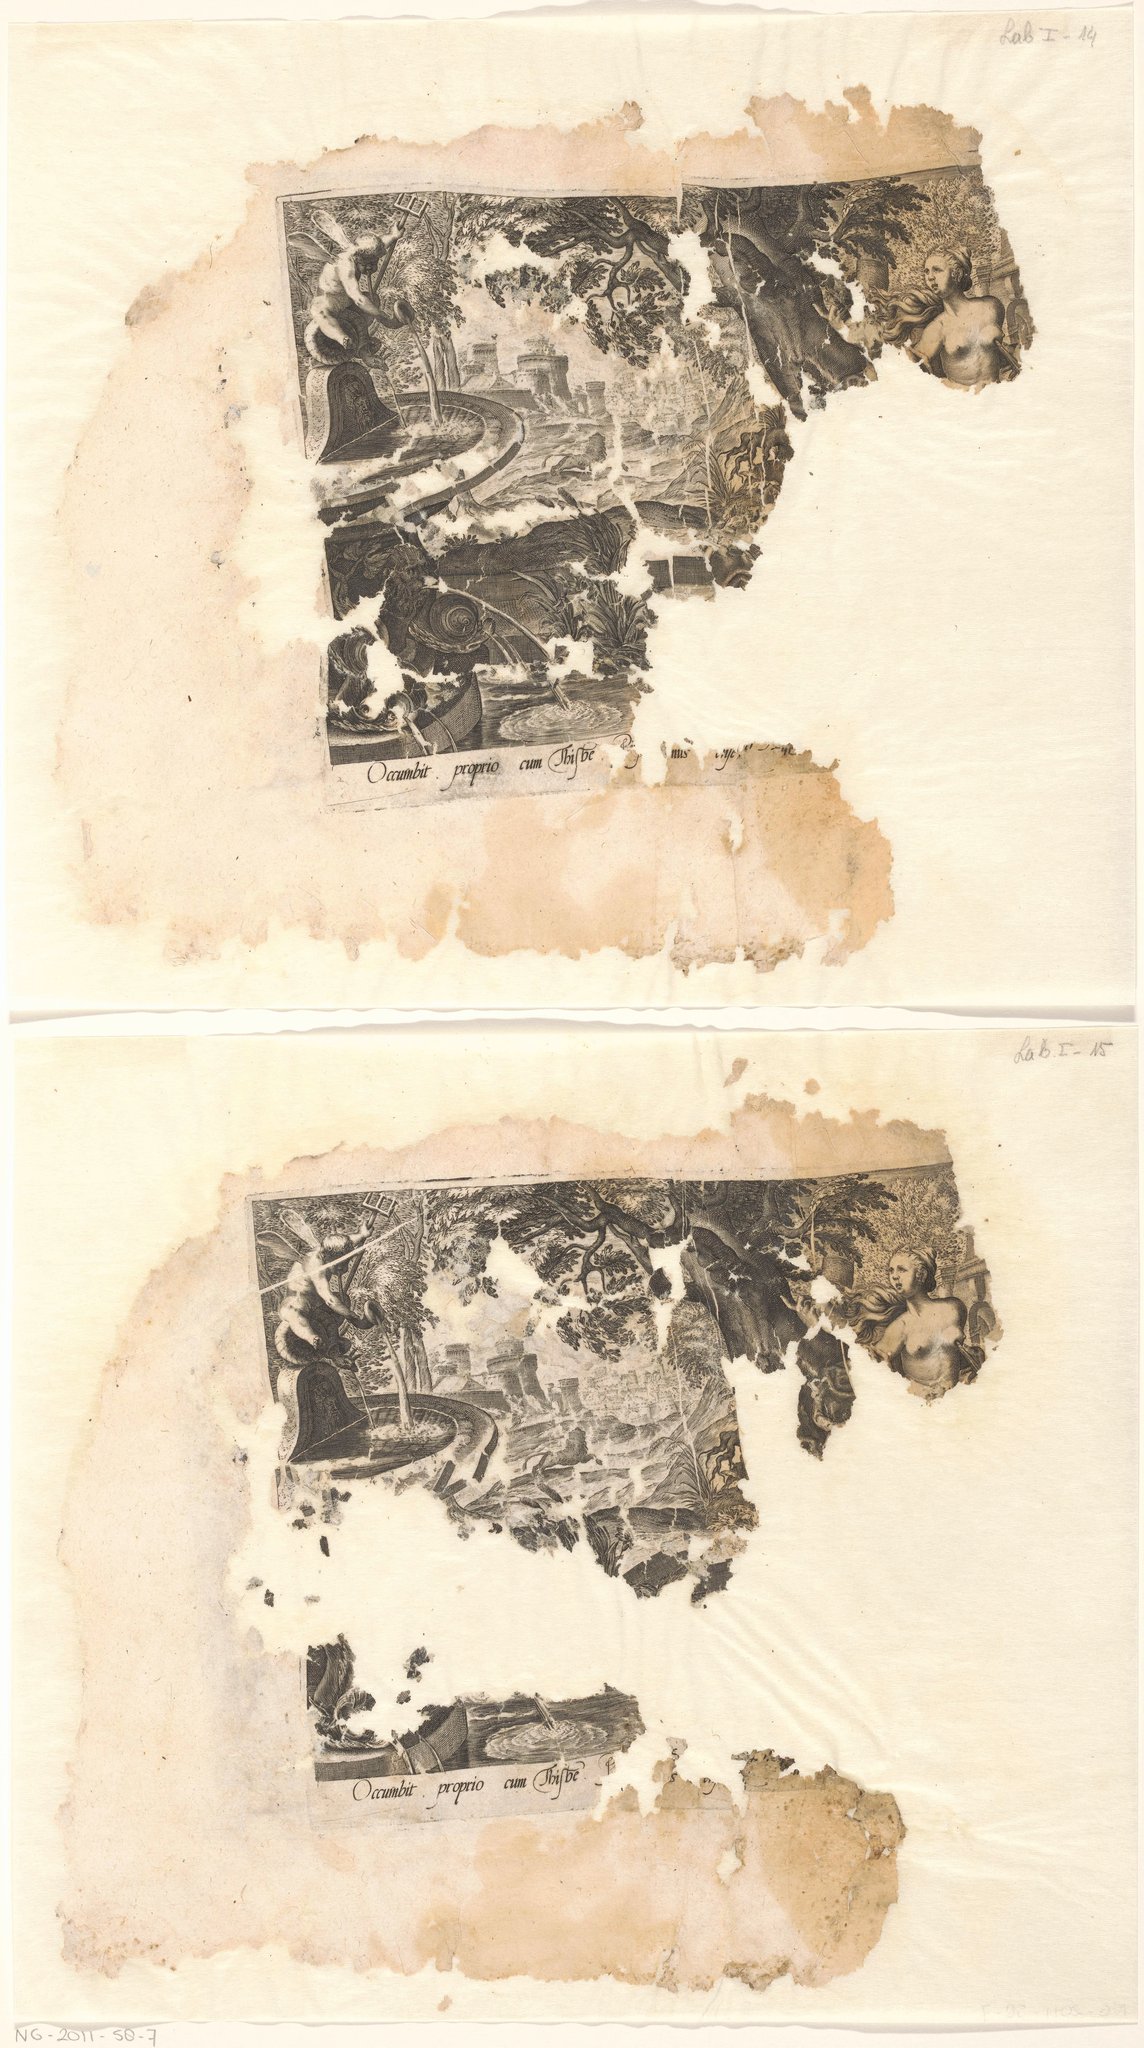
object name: print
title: Pyramus en Thisbe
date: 1580-1596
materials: paper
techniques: engraving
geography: northern netherlands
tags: thisbe kills herself with pyramus' sword (the scene may be represented near a fountain)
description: De prenten in de Nova Zembla collectie zijn tijdens een expeditie van Willem Barendsz en Jacob van Heemskerk in 1596-1597 noodgedwongen in het winterkamp, het ‘Behouden Huis’, op het eiland achtergelaten. De prenten waren in één of meerdere stapels als handelswaar meegenomen vanuit Amsterdam. Bijna drie eeuwen later, in 1871, keerde de Noor Elling Carlsen terug naar Nova Zembla en vond daar de restanten van het ‘Behouden Huis, inclusief een groot deel van de inventaris. Een deel van de prenten, in de vorm van aaneengekoekte kluiten, werd toen ook teruggevonden. De papierkluiten waren soms op meerdere plekken gebroken. Tussen 1975-1979 zijn de prenten van elkaar gescheiden. Dit leverde in totaal ca. 1000 fragmenten van ca. 400 afdrukken van ca. 150 verschillende prenten op. Voor zover mogelijk zijn de fragmenten samengevoegd en zijn de prenten gereconstrueerd.